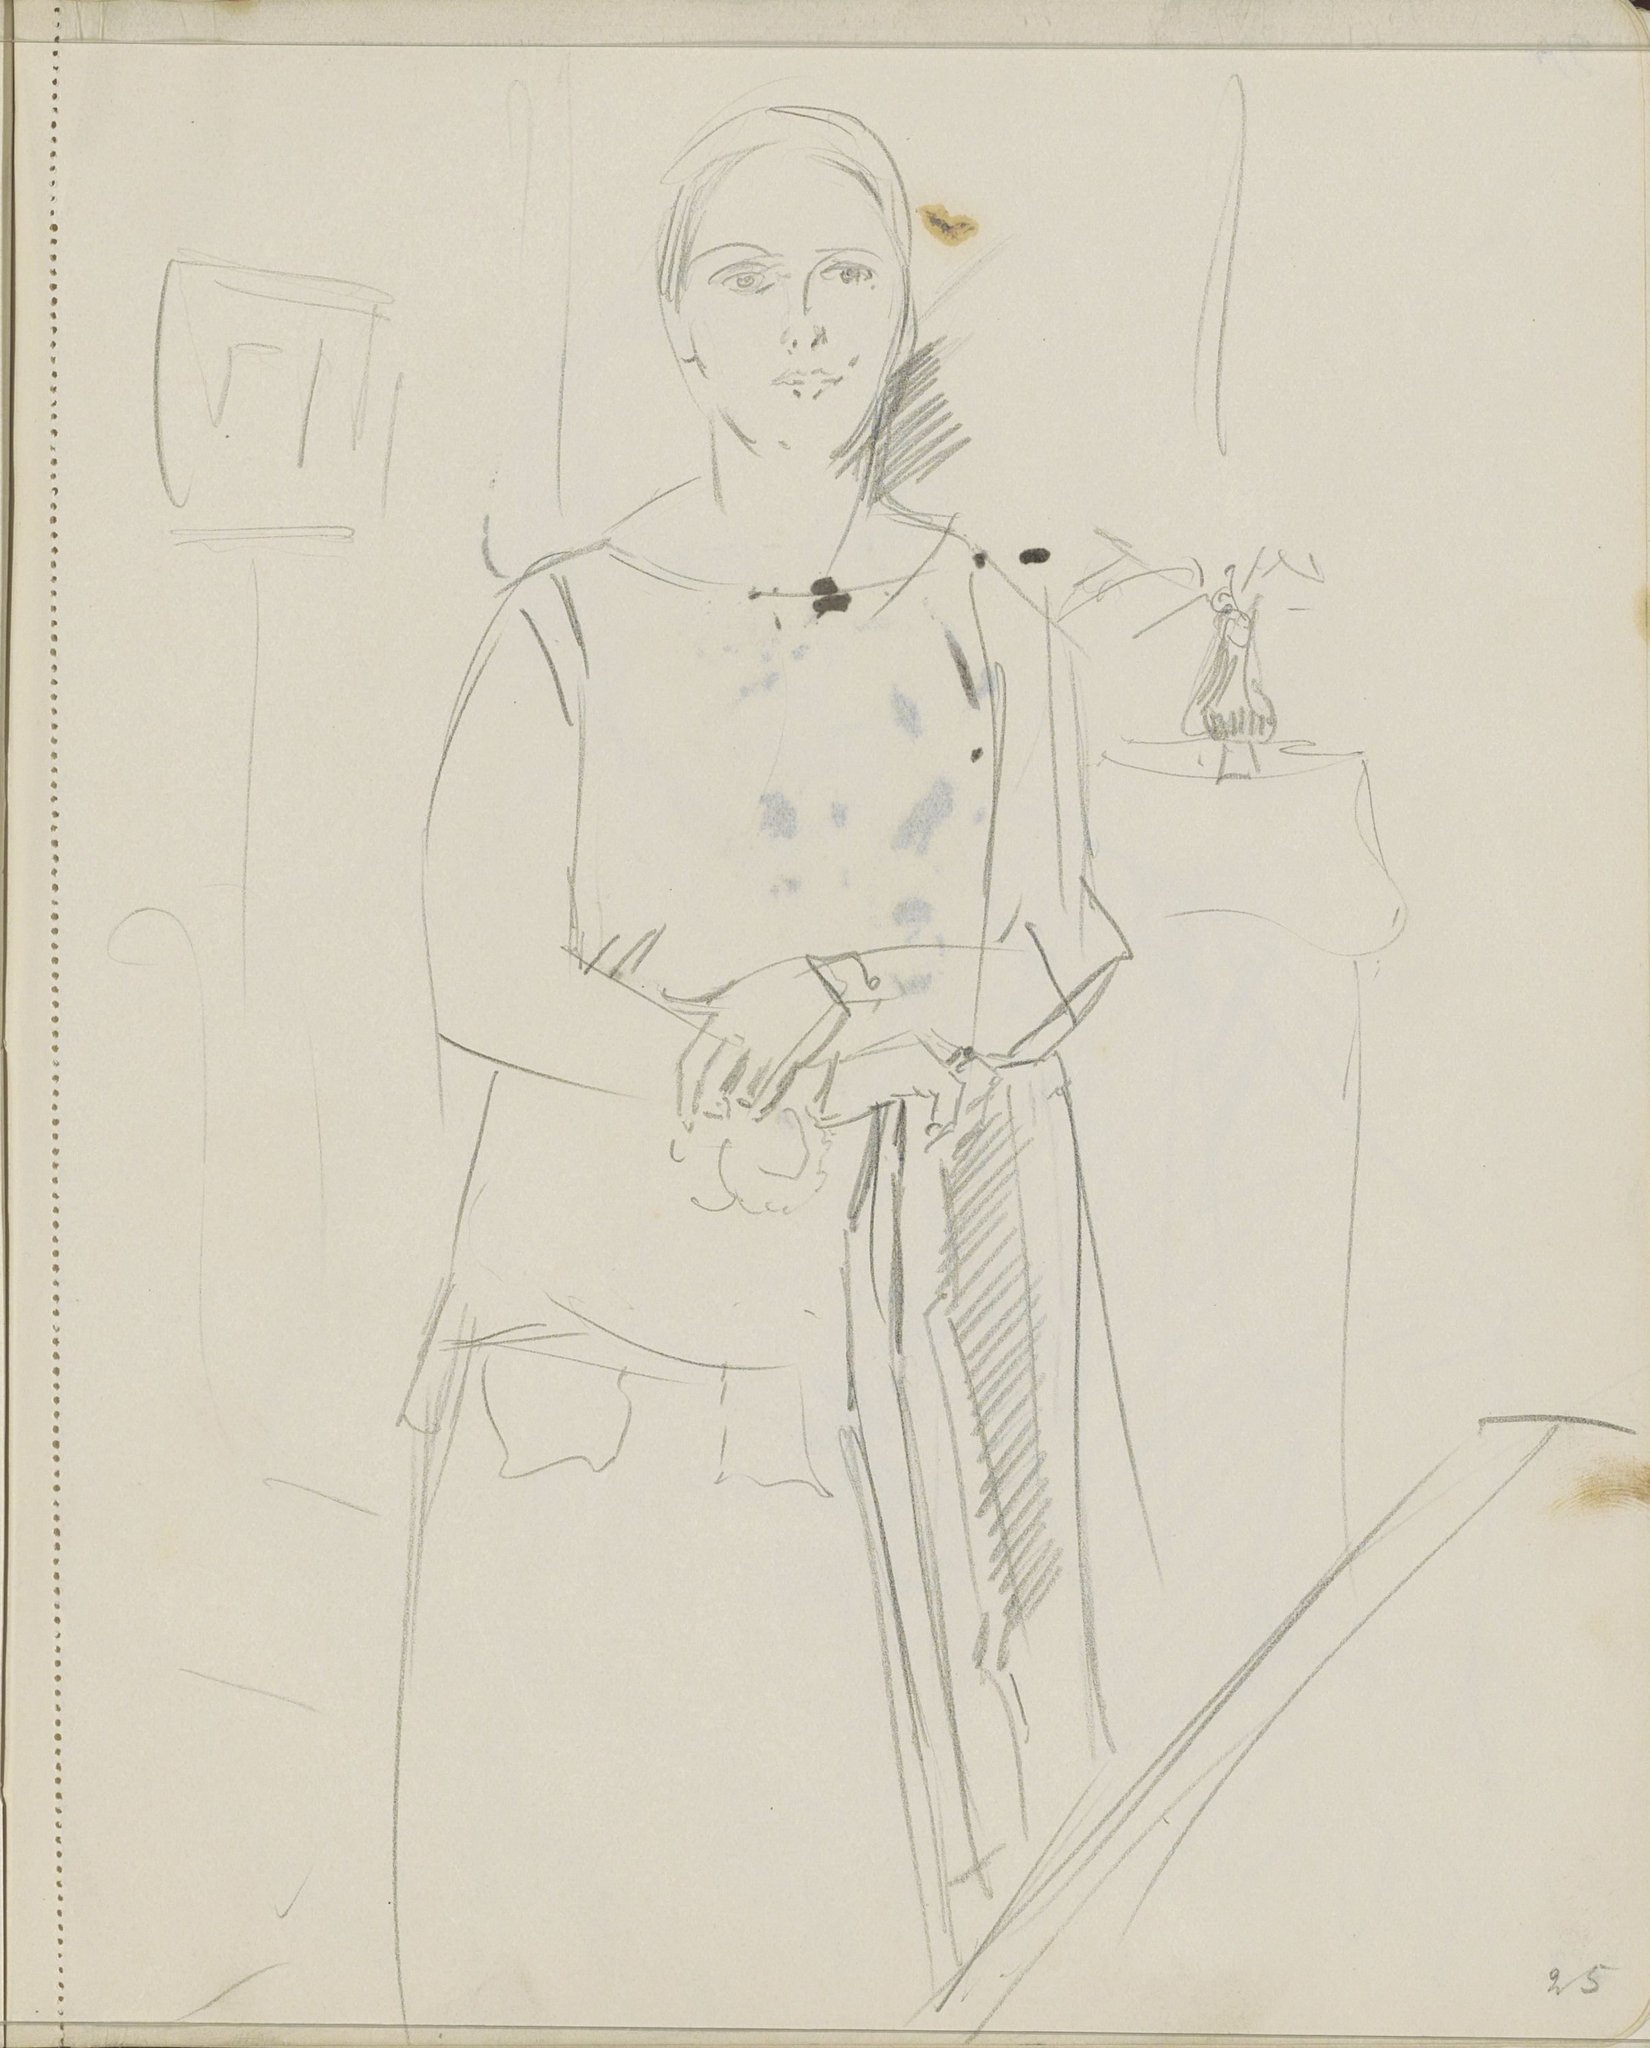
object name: sketchbook leaf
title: Staande vrouw in een interieur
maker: isaac israels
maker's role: draughtsman, painter, print maker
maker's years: 1865-1934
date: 1925-1934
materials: paper, pencil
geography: the hague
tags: adult woman (+ standing), interior of the house, chair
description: Ze leunt op de rugleuning van een stoel. Blad 25 recto uit schetsboek XXVI met 35 bladen.